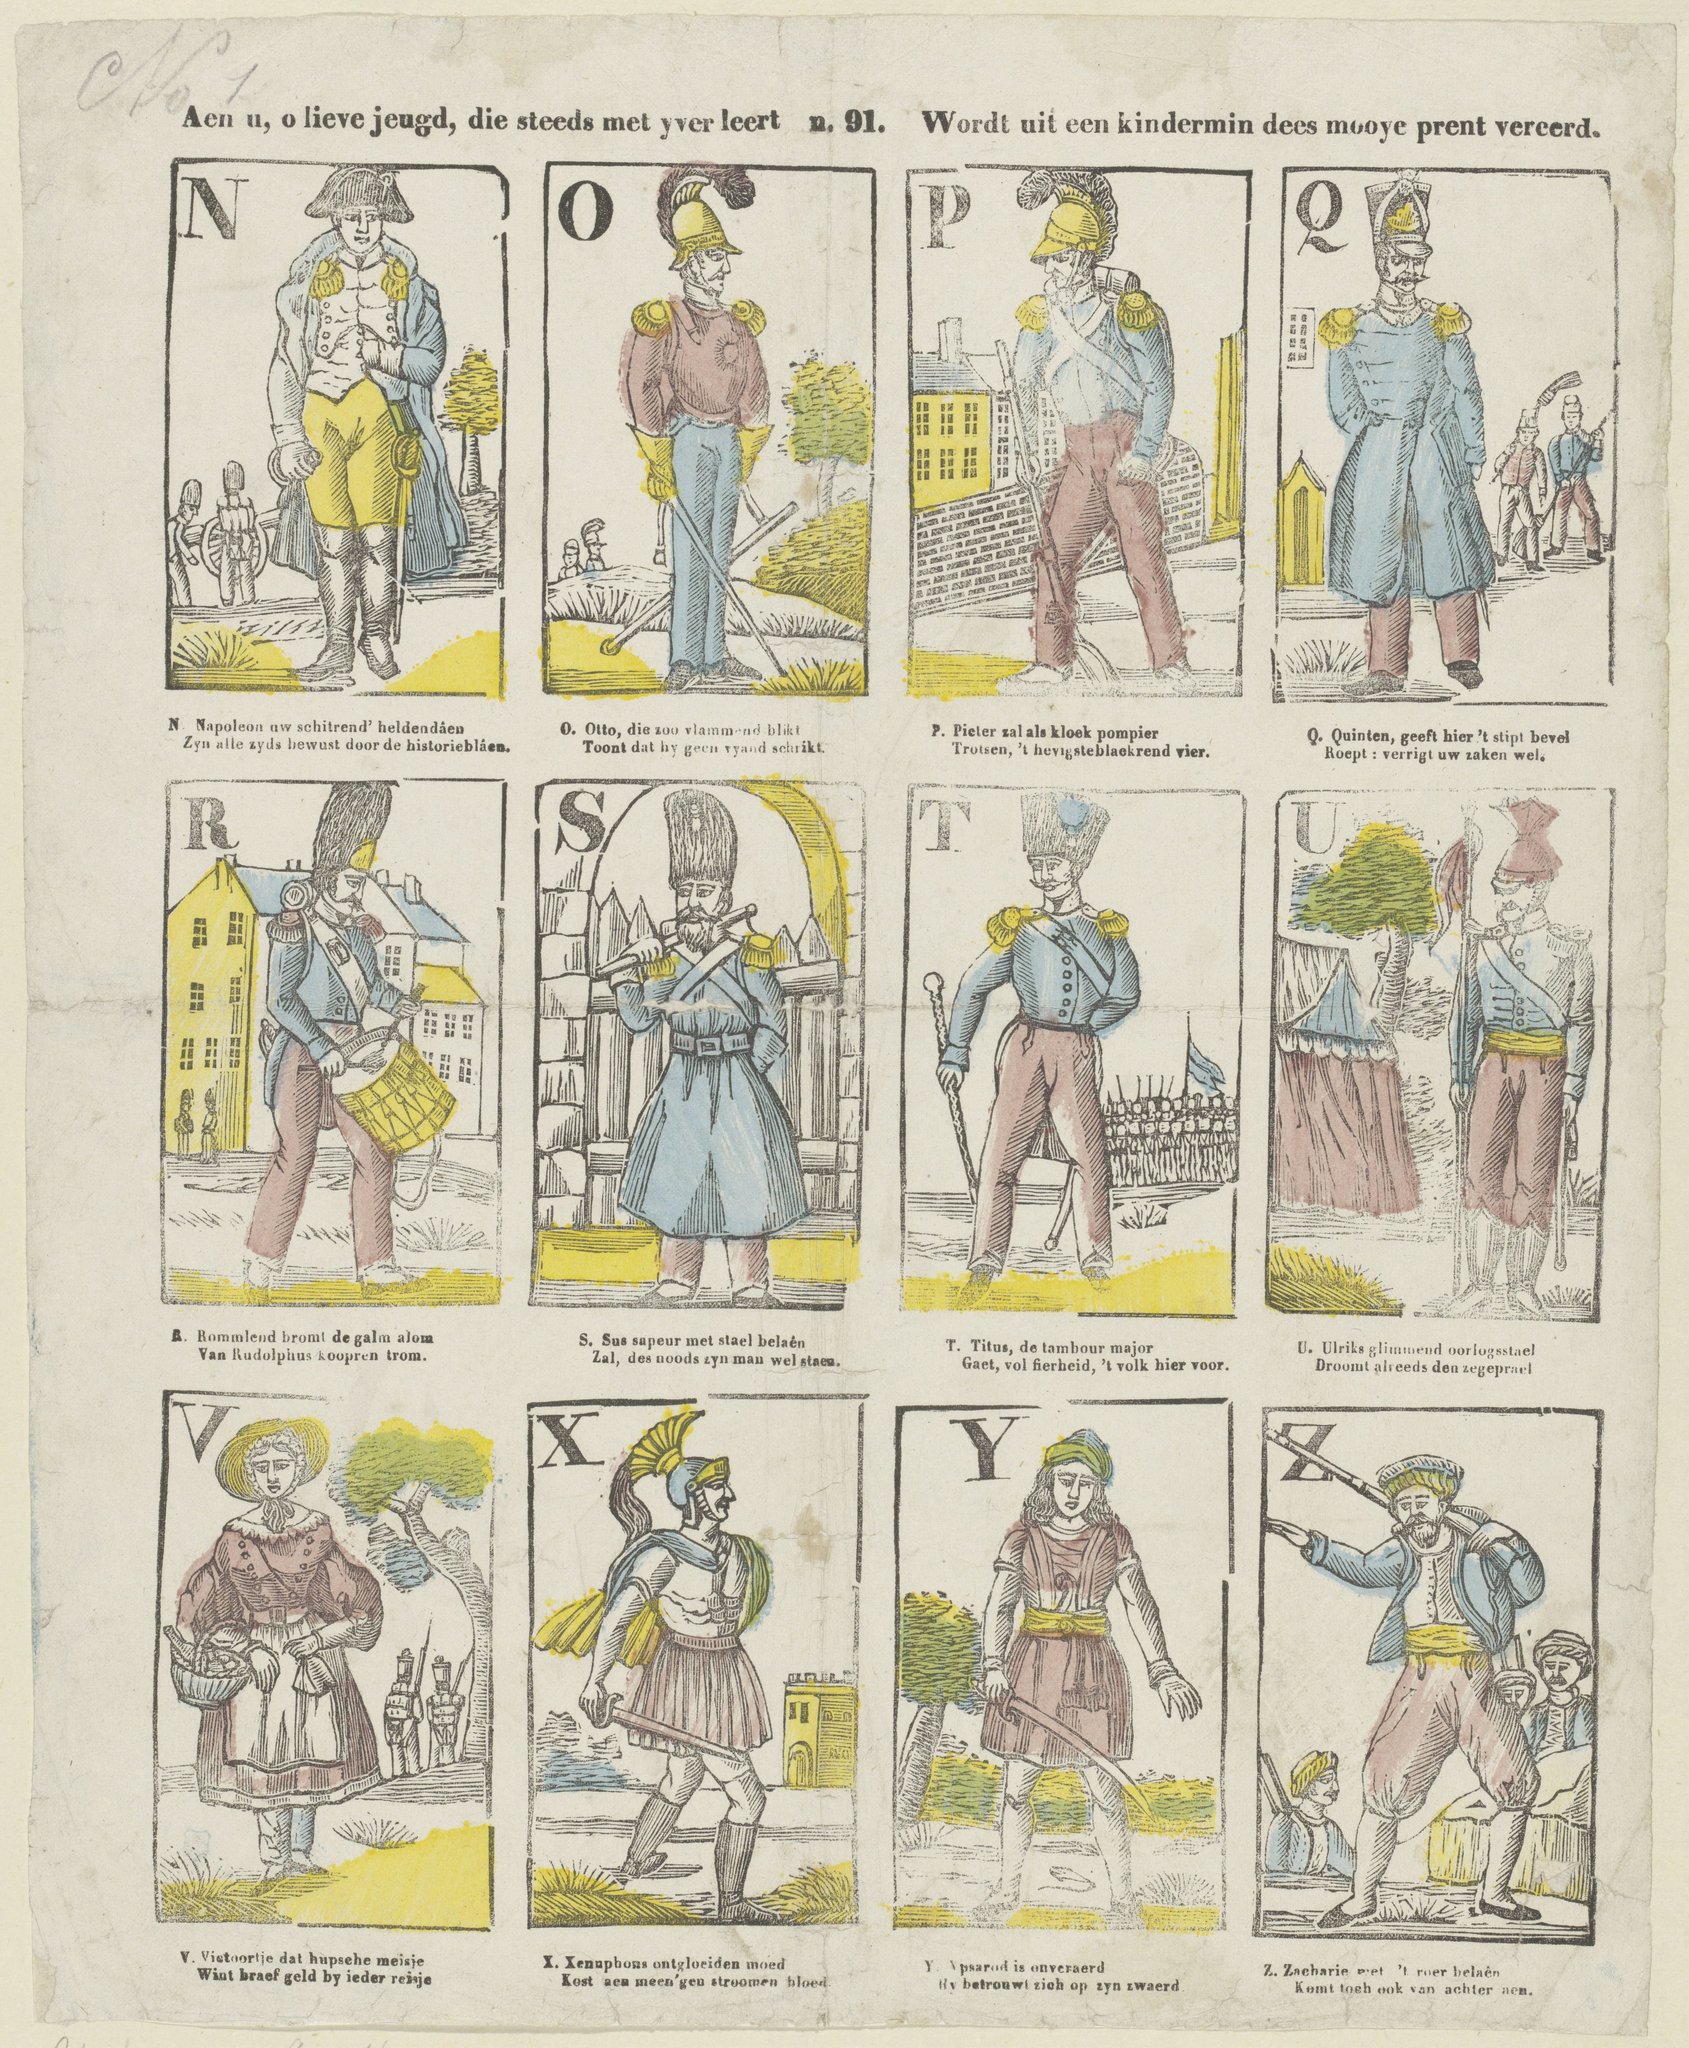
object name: print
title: Aen u, o lieve jeugd, die steeds met yver leert / Wordt uit een kindermin dees mooye prent vereerd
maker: Anonymous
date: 1833-1870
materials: paper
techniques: colour, letterpress printing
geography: netherlands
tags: the individual and his name, letters, alphabet, script, characters (human types)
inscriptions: collector's mark: Lugt 2760, inscription: ‘No 1’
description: Blad met 12 voorstellingen van de letters van het alfabet (N-Z) geïllustreerd met figuren waarvan de namen met de betreffende letter beginnen. Onder elke afbeelding een tweeregelig vers. Genummerd midden boven: n. 91.